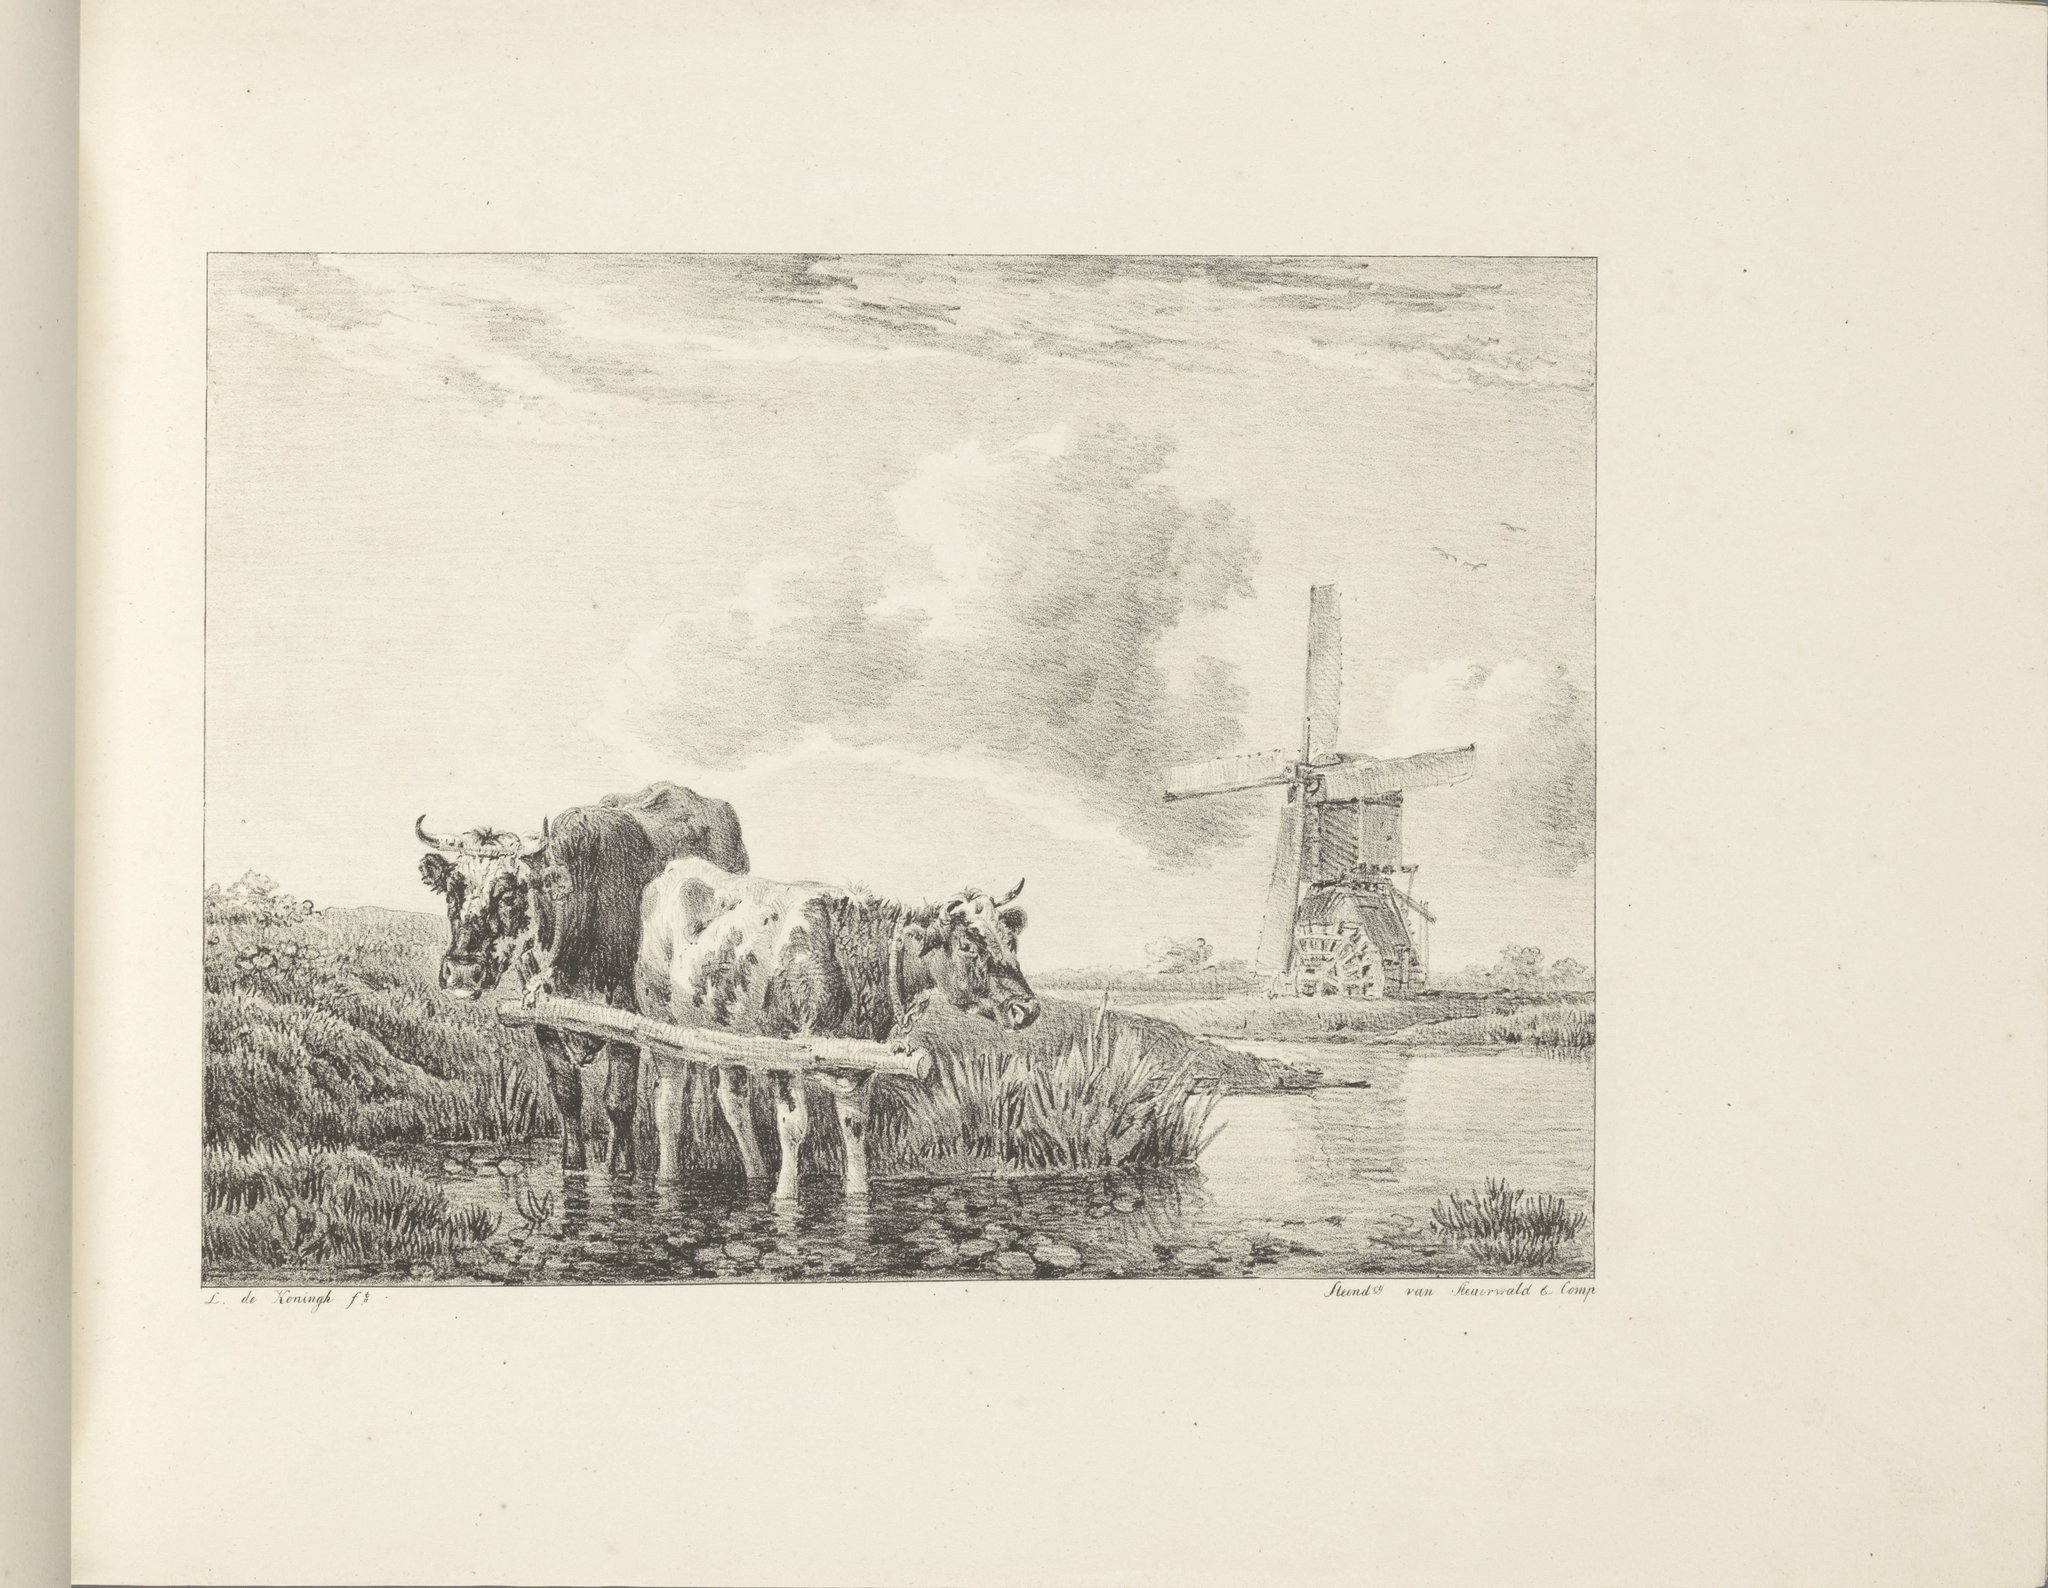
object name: print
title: Teekeningen naar Beesten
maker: leendert de koningh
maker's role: draughtsman, print maker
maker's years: 1777-1849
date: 1826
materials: paper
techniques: lithograph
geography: dordrecht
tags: cow, windmill in landscape, landscapes in the temperate zone (+ landscape with figures, staffage)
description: De koeien zijn met een balk aan elkaar bevestigd. Deze prent behoort tot een serie van zes prenten, samengebonden met een titelblad.